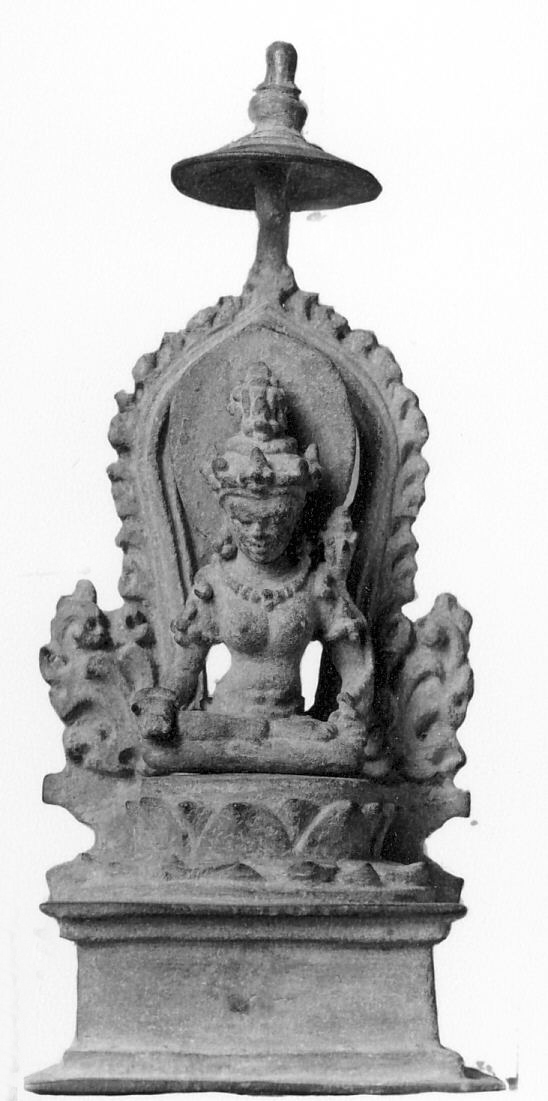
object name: figure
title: Seated Devi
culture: indonesian, javanese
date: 801-900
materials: bronze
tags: goddess